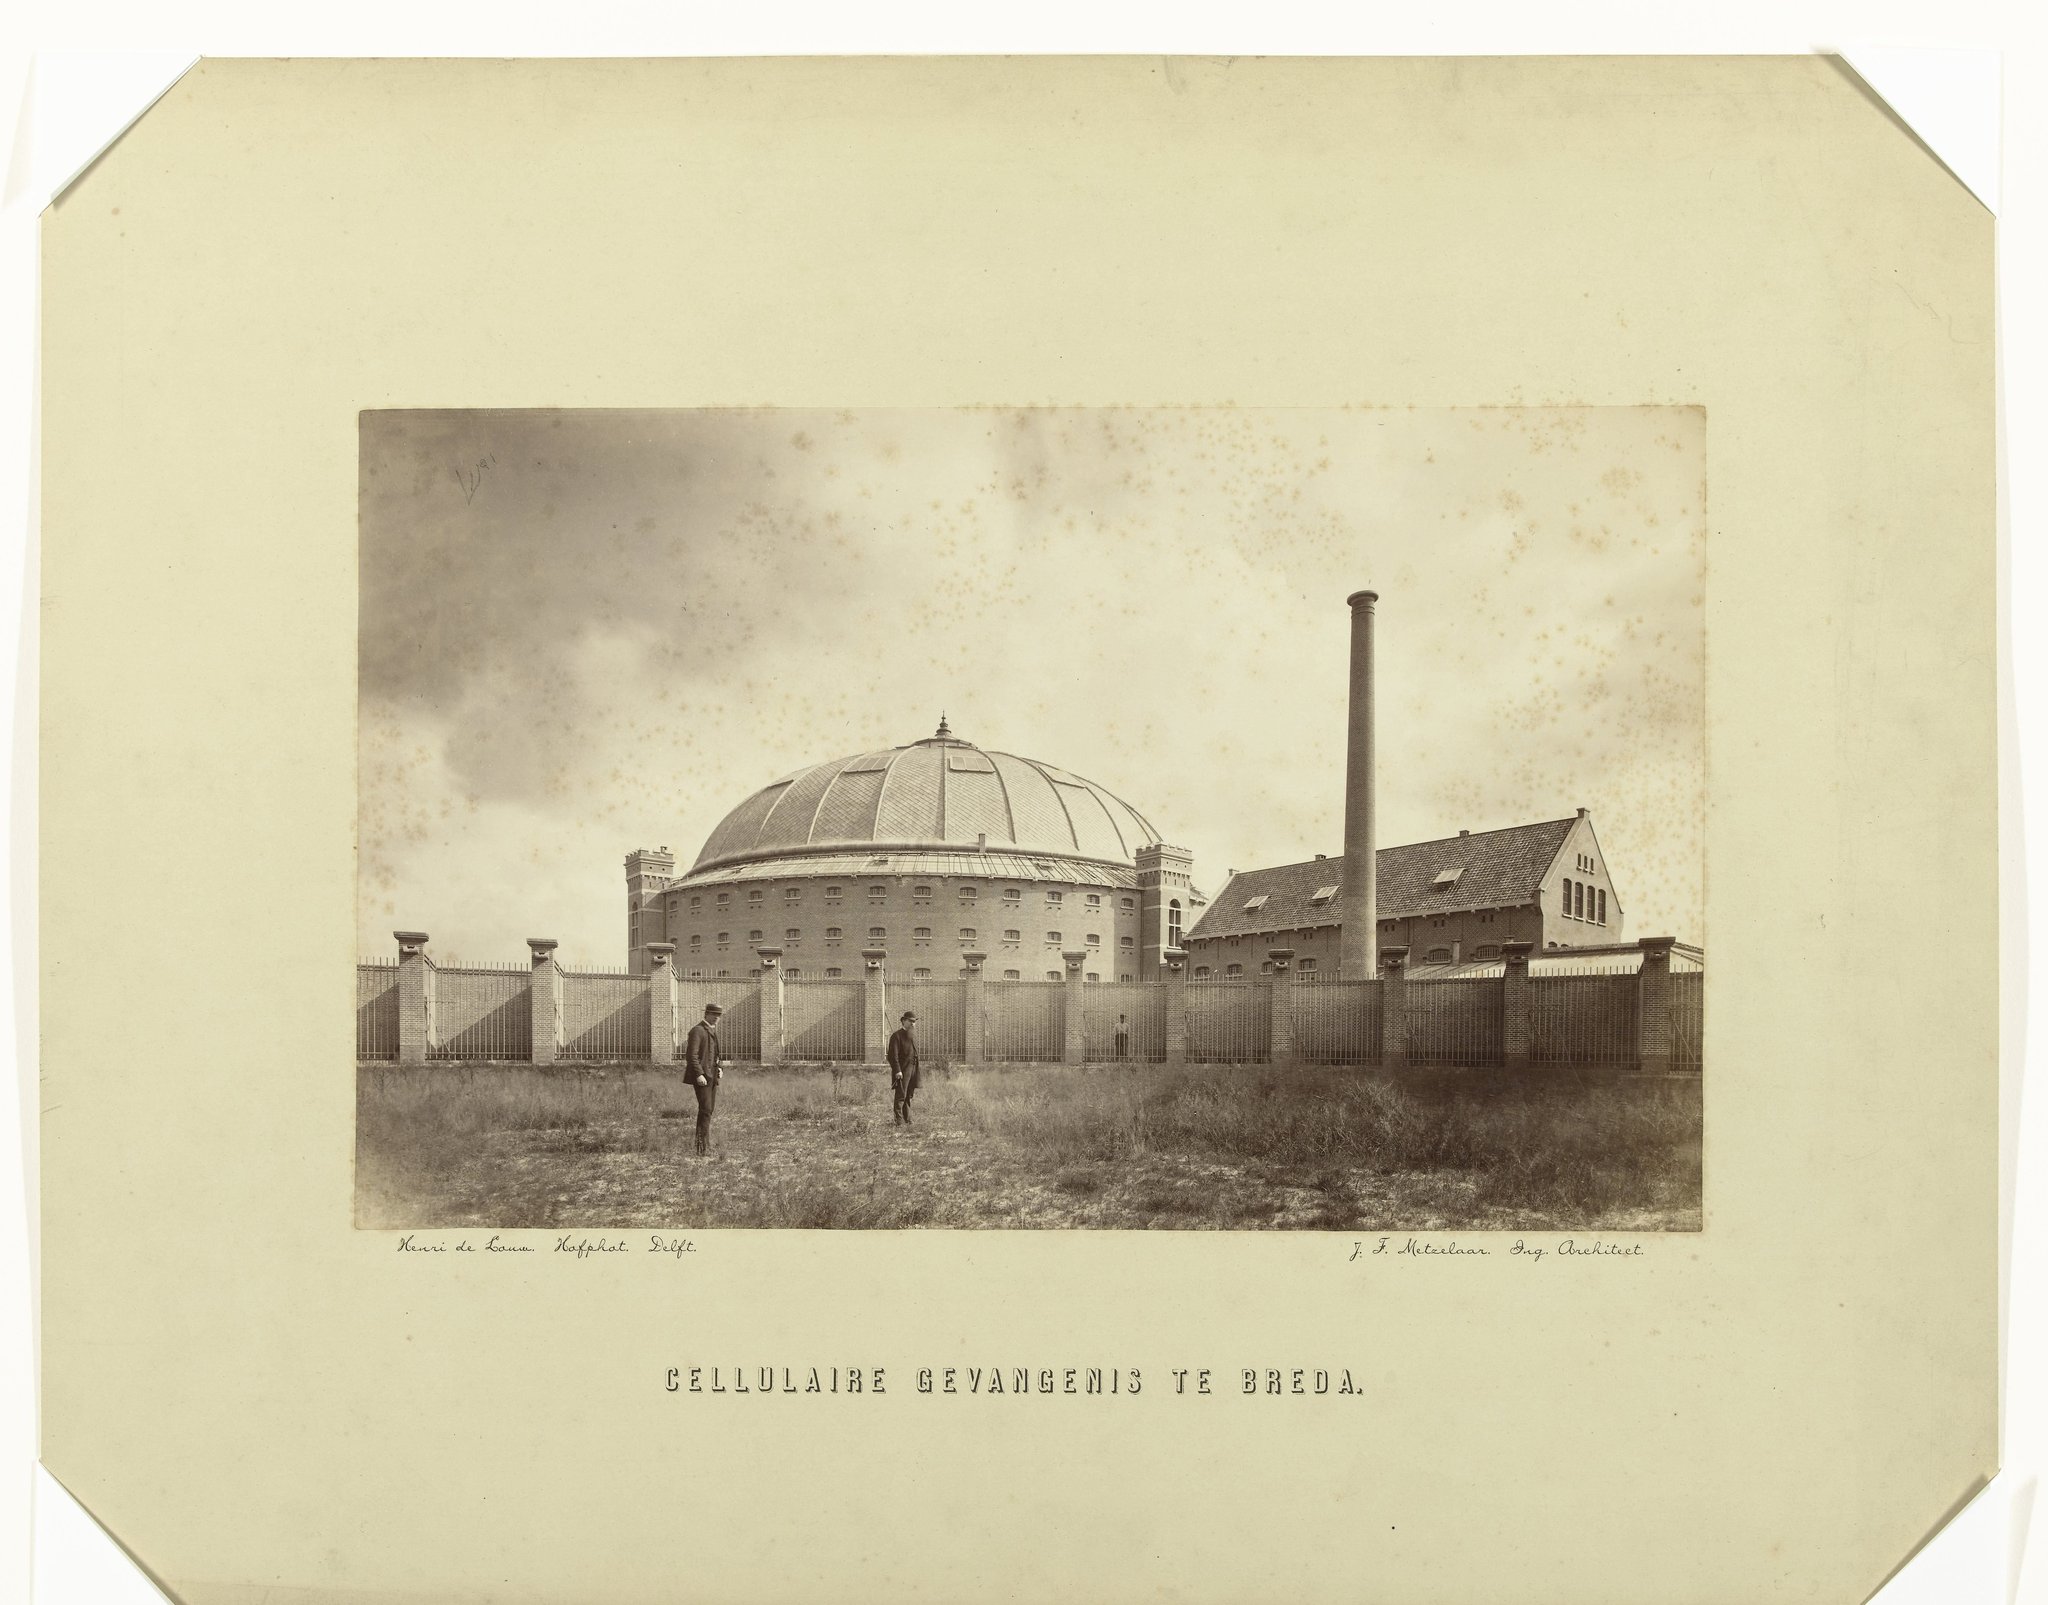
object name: photograph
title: De gevangenis van Breda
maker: henri de louw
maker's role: fotograaf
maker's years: 1851-1944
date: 1886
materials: cardboard, photographic support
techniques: albumen print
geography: the hague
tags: prison, jail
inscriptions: caption: ‘J.F. Metzelaar Ing. Architect’